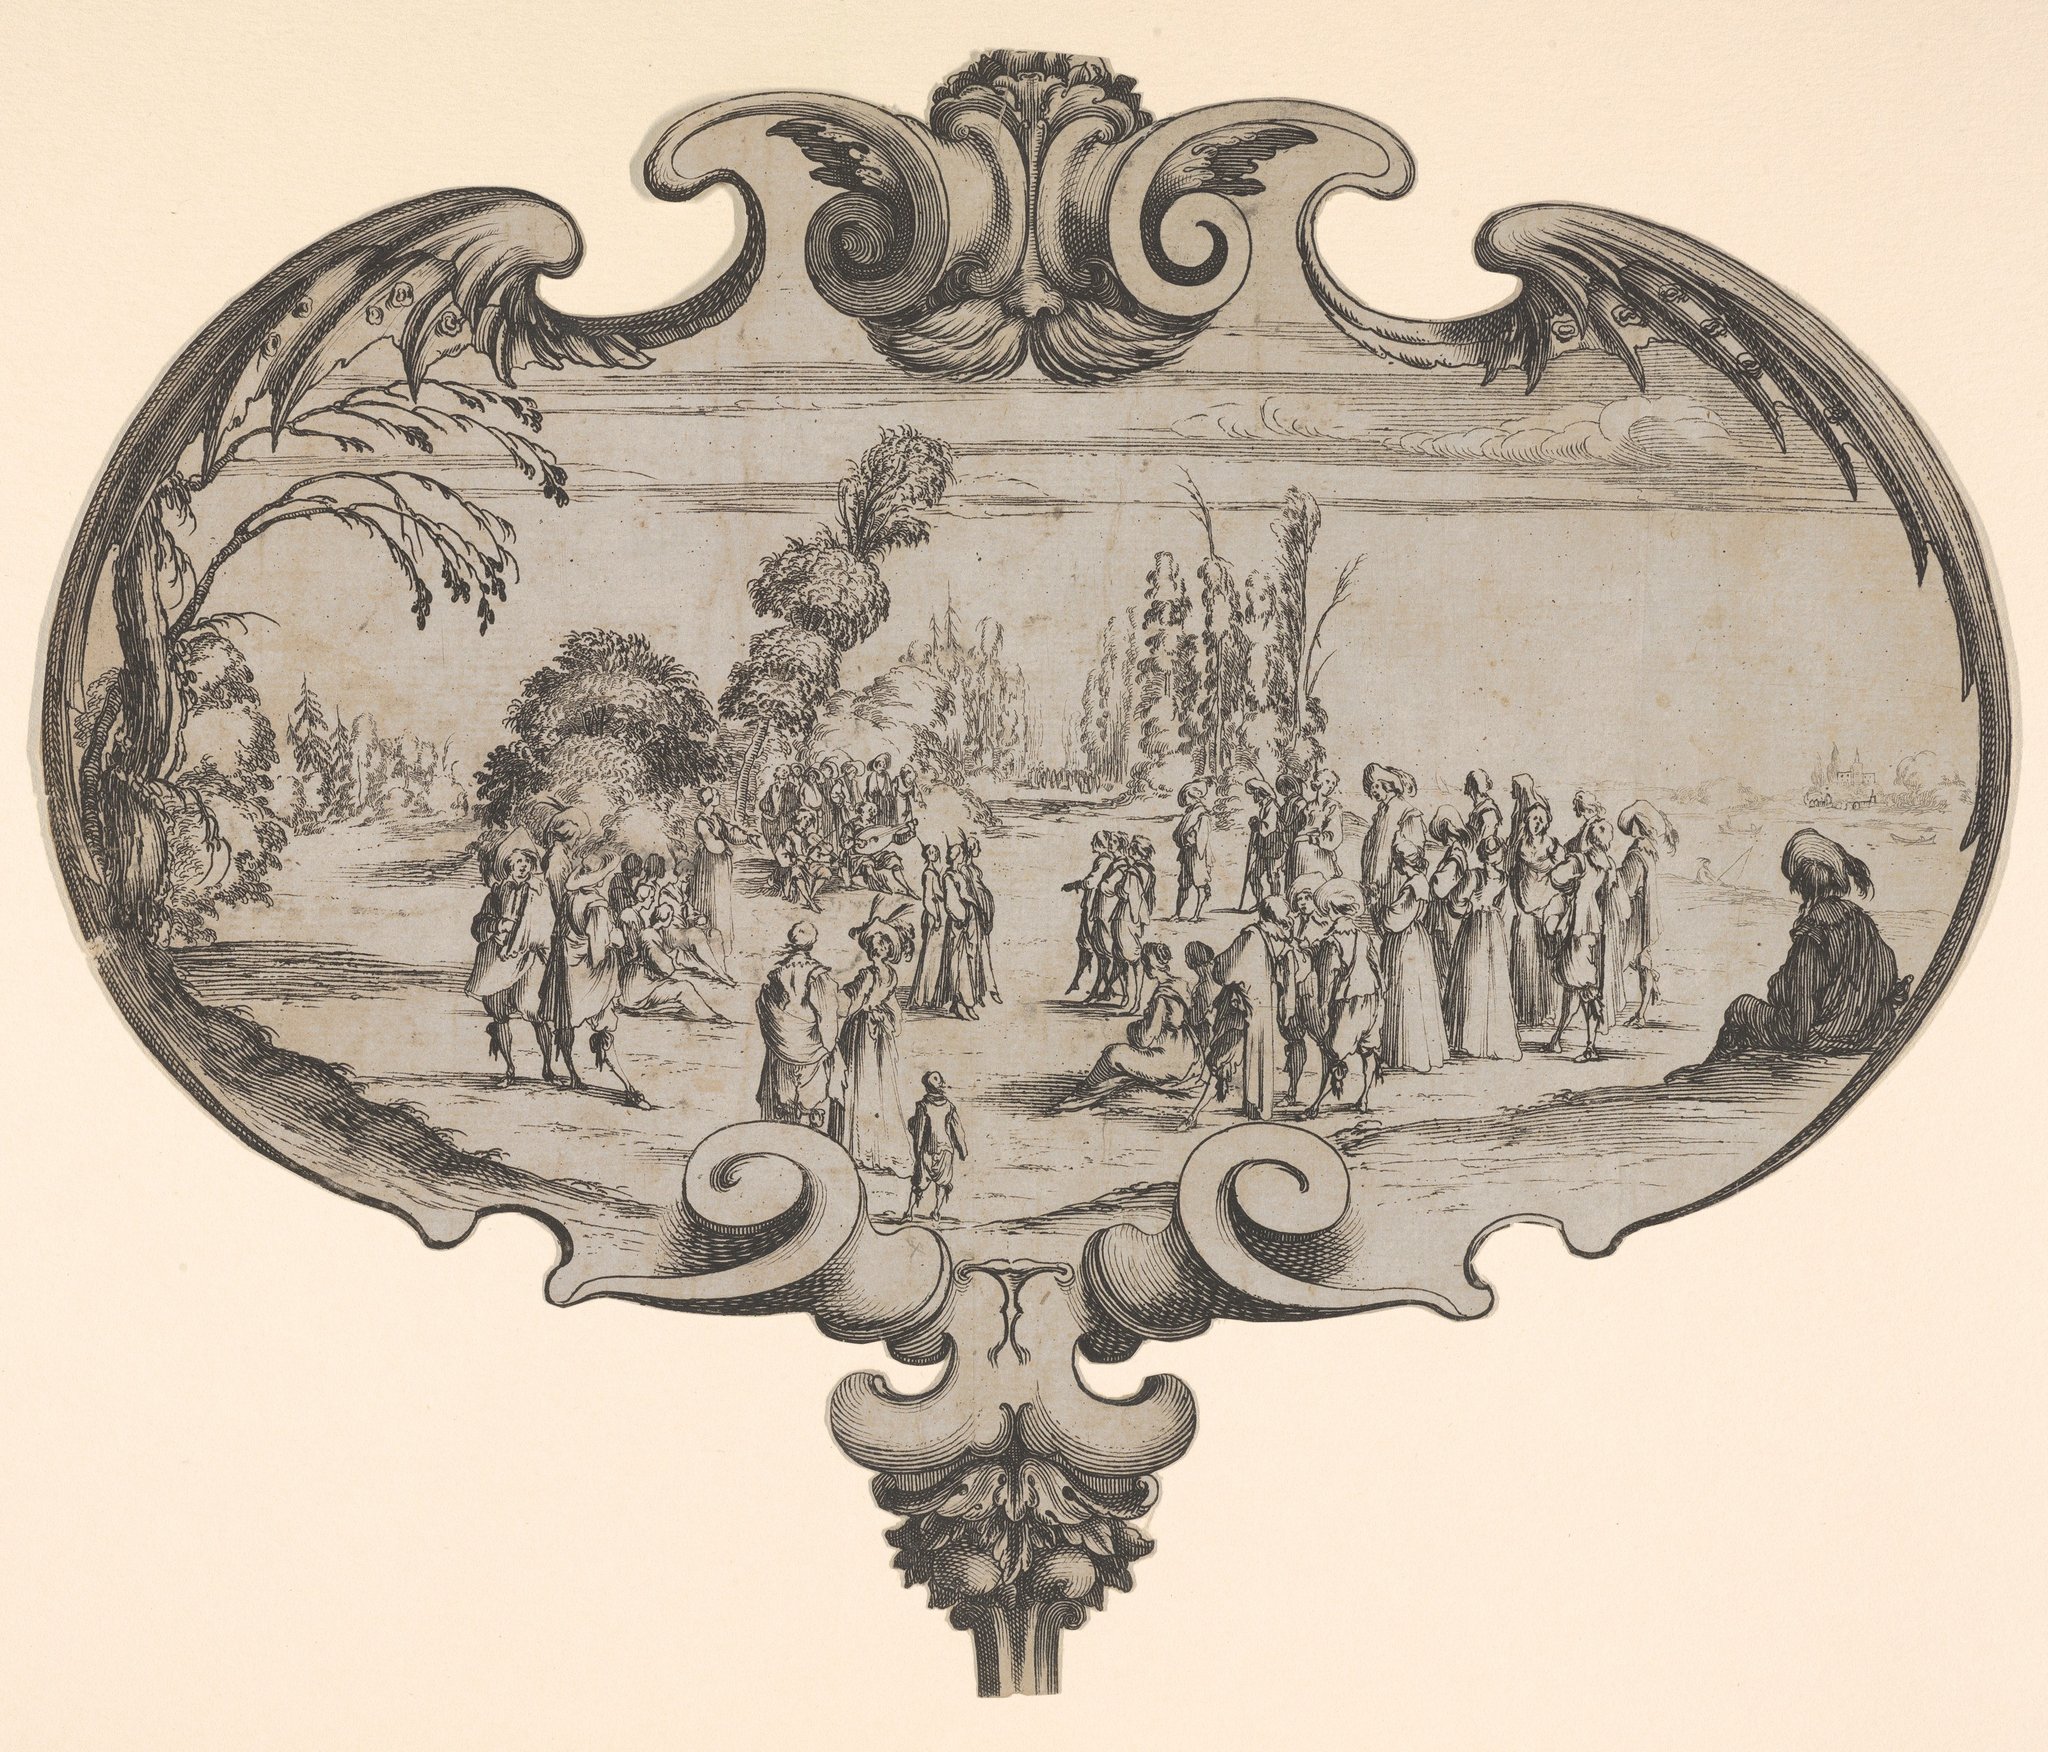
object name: print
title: A fan with a musical troupe and spectators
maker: stefano della bella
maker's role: artist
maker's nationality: italian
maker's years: 1610-1664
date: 1633-1638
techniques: etching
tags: men,women,spectators,musicians